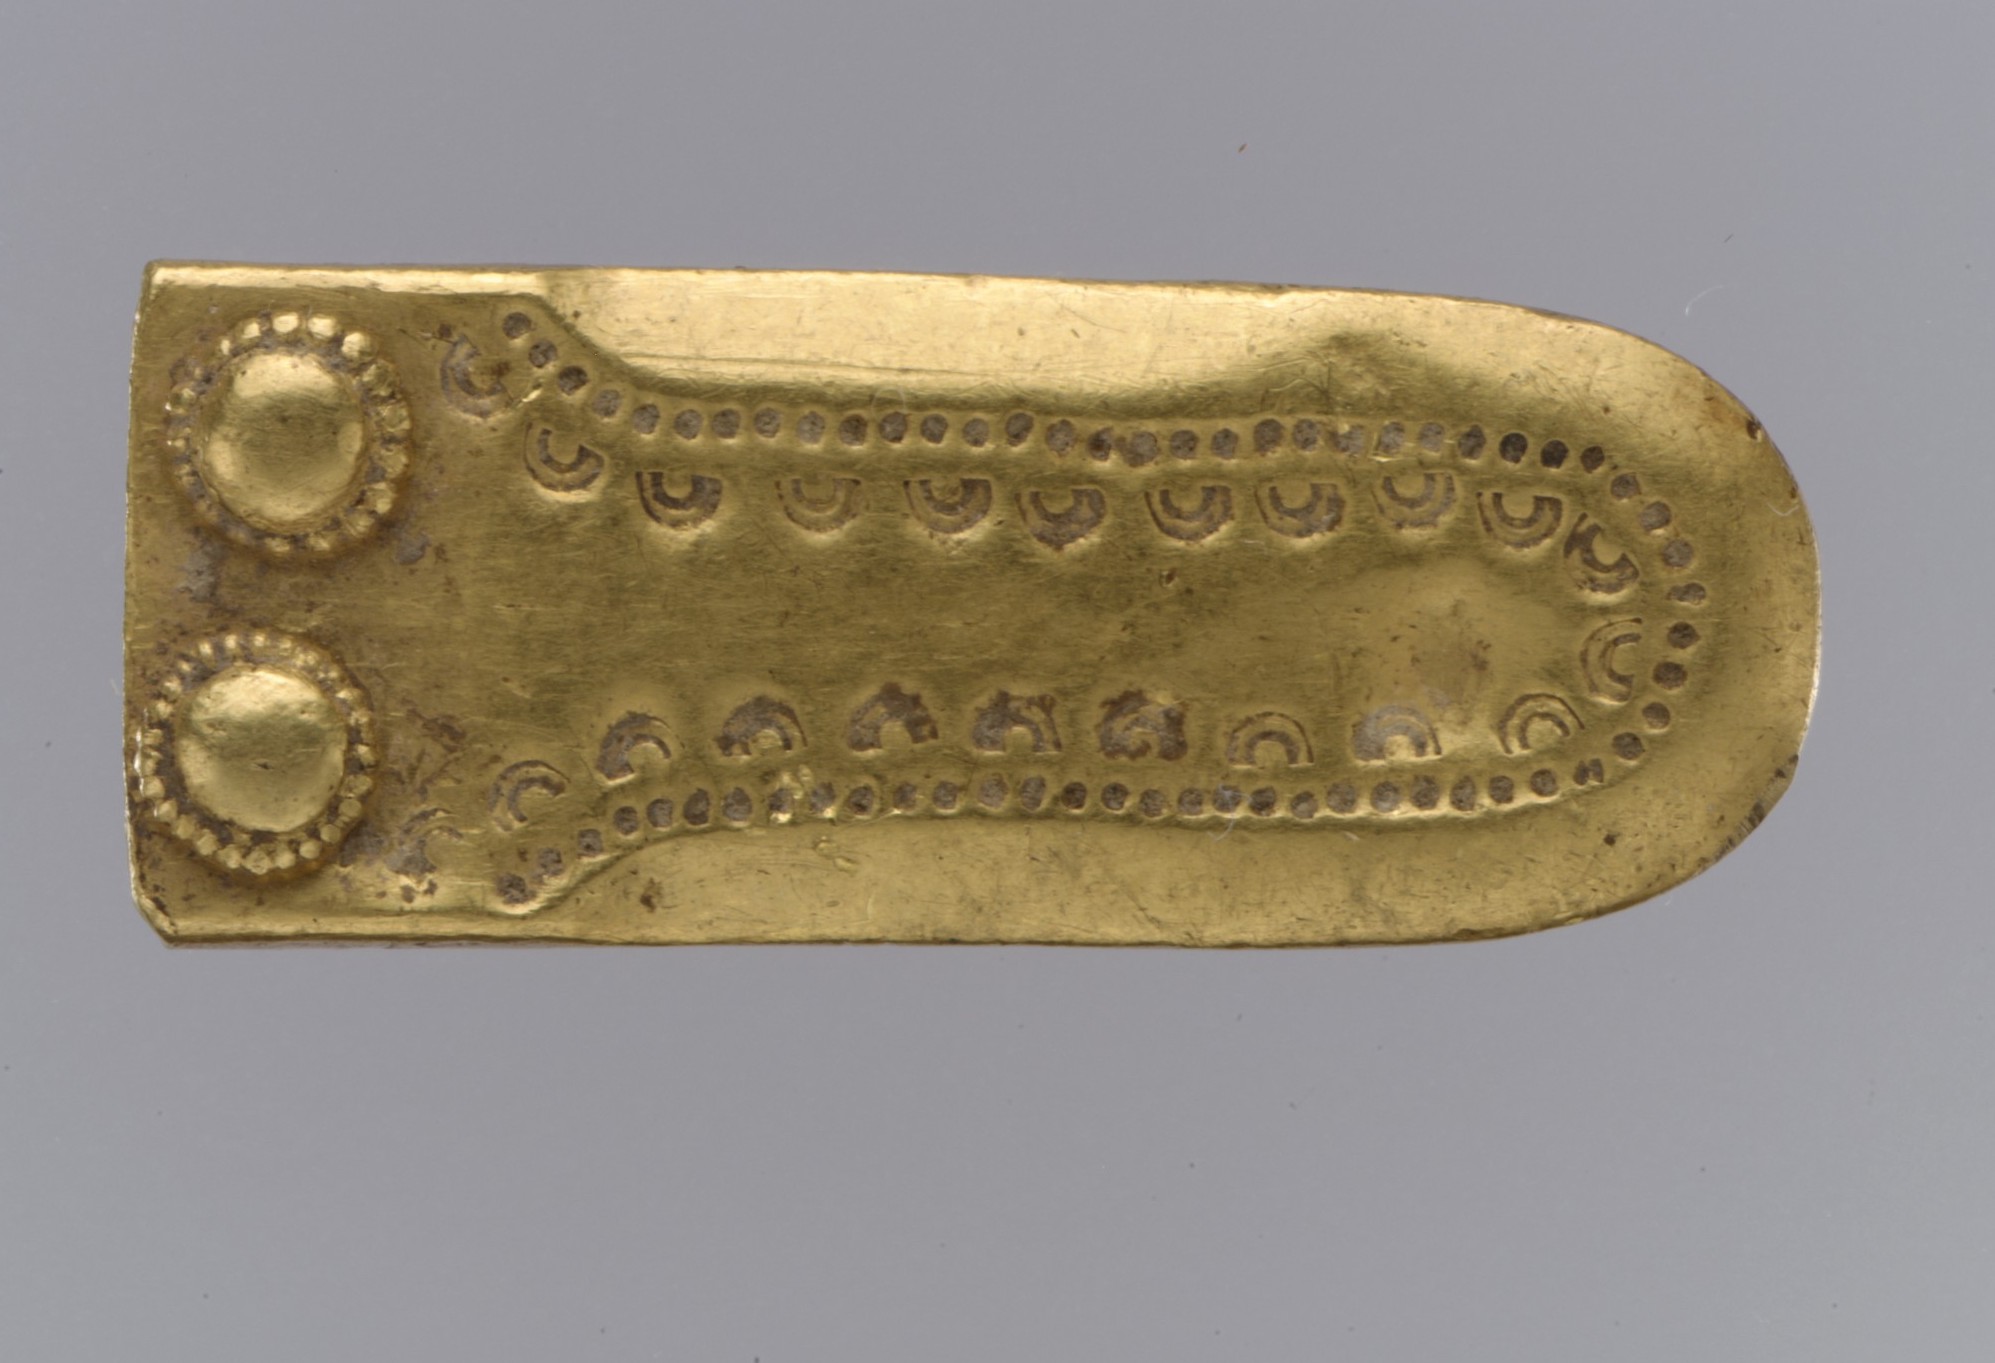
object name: shoe buckle strap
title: Gold Strap End from a Shoe Buckle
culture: langobardic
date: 600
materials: gold